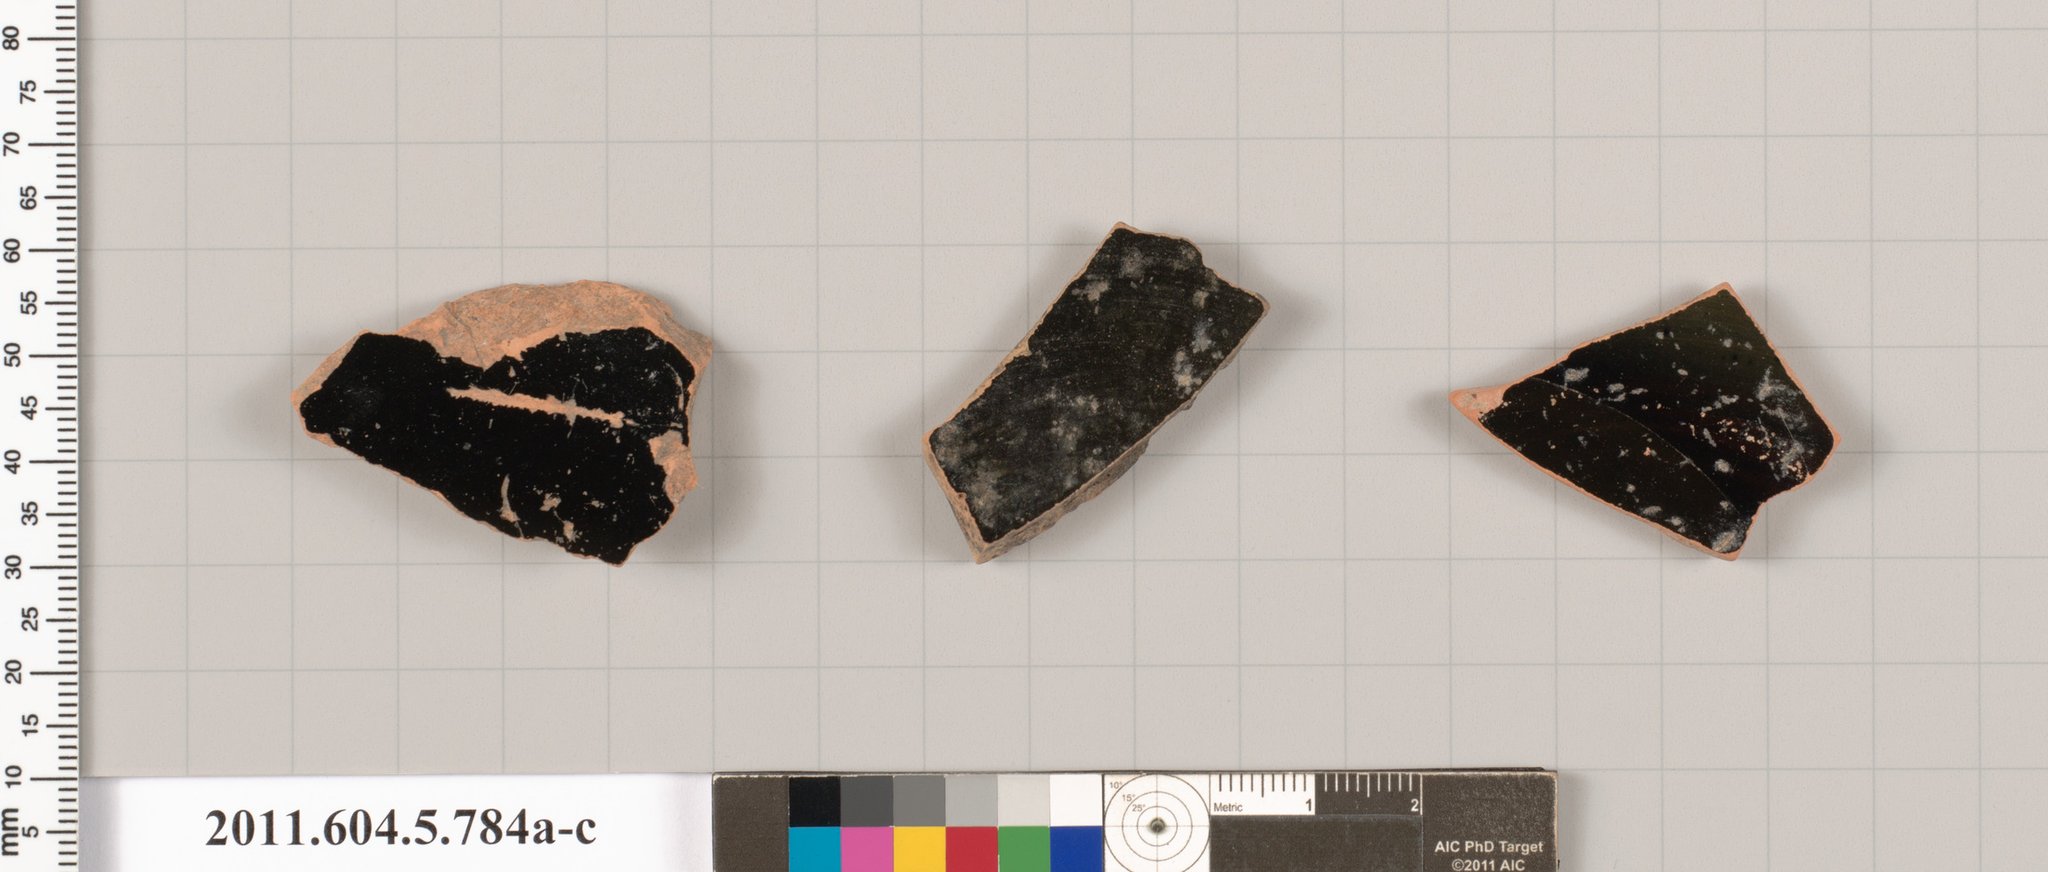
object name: kylix fragment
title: Terracotta fragments of kylikes (drinking cups)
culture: greek, attic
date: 600-401 BCE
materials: terracotta